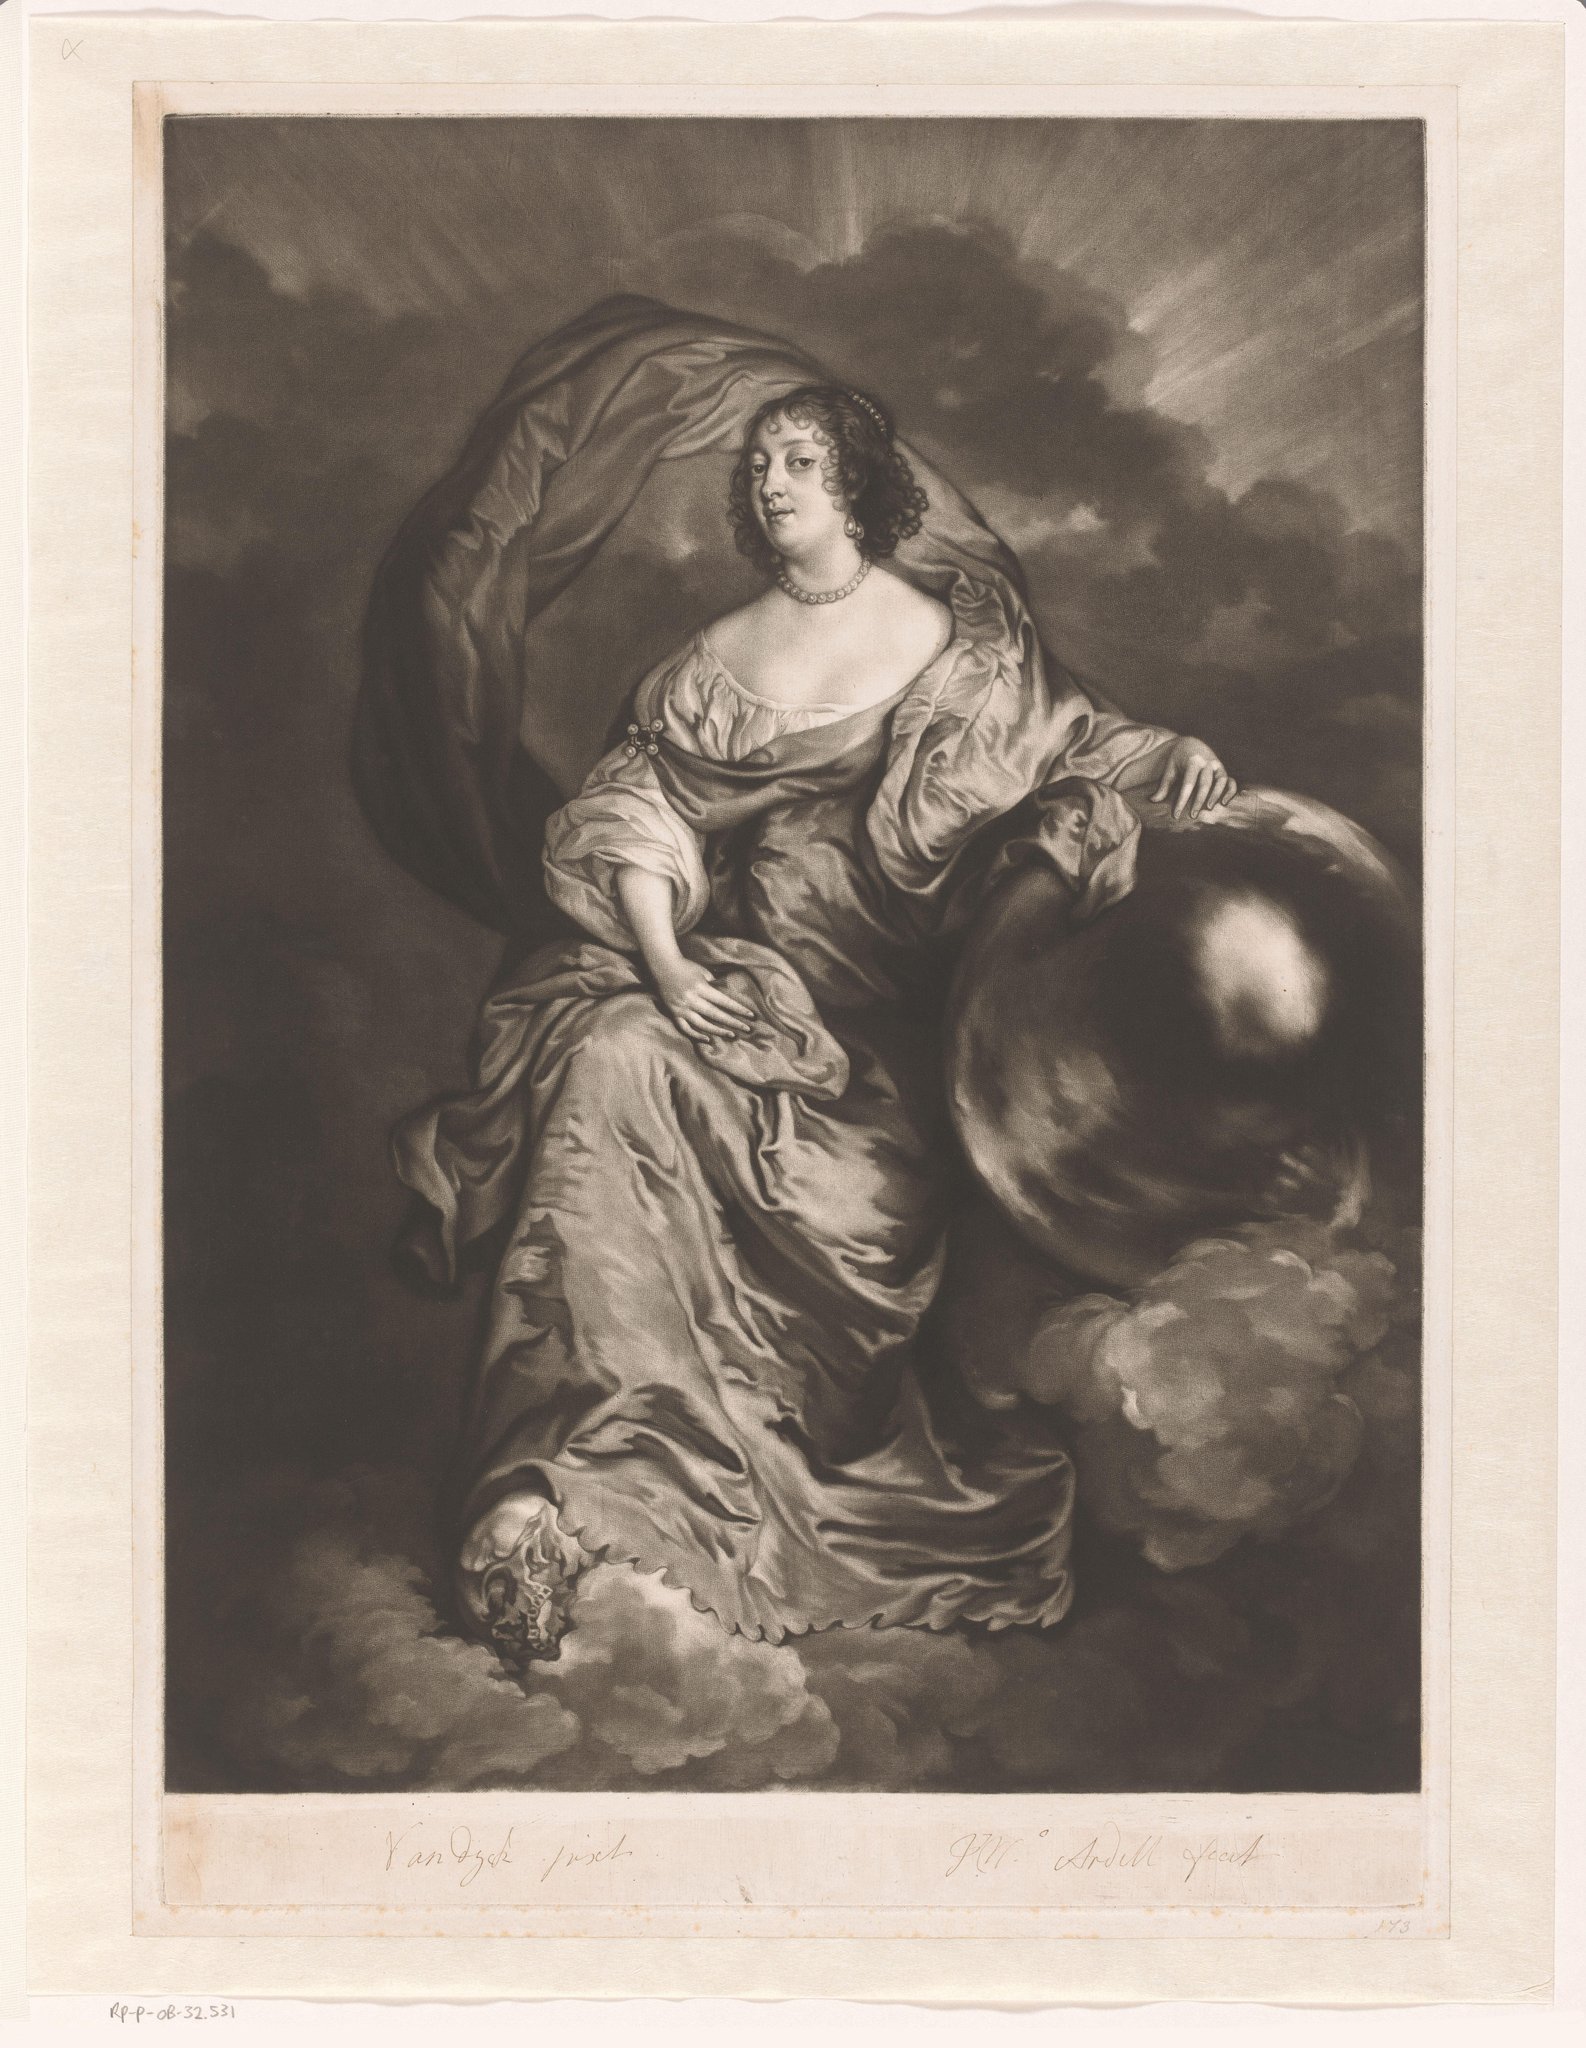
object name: print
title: Portret van Rachel Wriothesley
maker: james mcardell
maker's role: print maker, publisher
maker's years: 1728-1765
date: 1758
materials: paper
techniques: mezzotint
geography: london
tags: (human) skull, historical persons - bb - woman, clouds, sphere, globe ~ stereometry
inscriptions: inscription: ‘Van dyck pinxt. J.Mc Ardell fecit’, collector's mark: Lugt 240